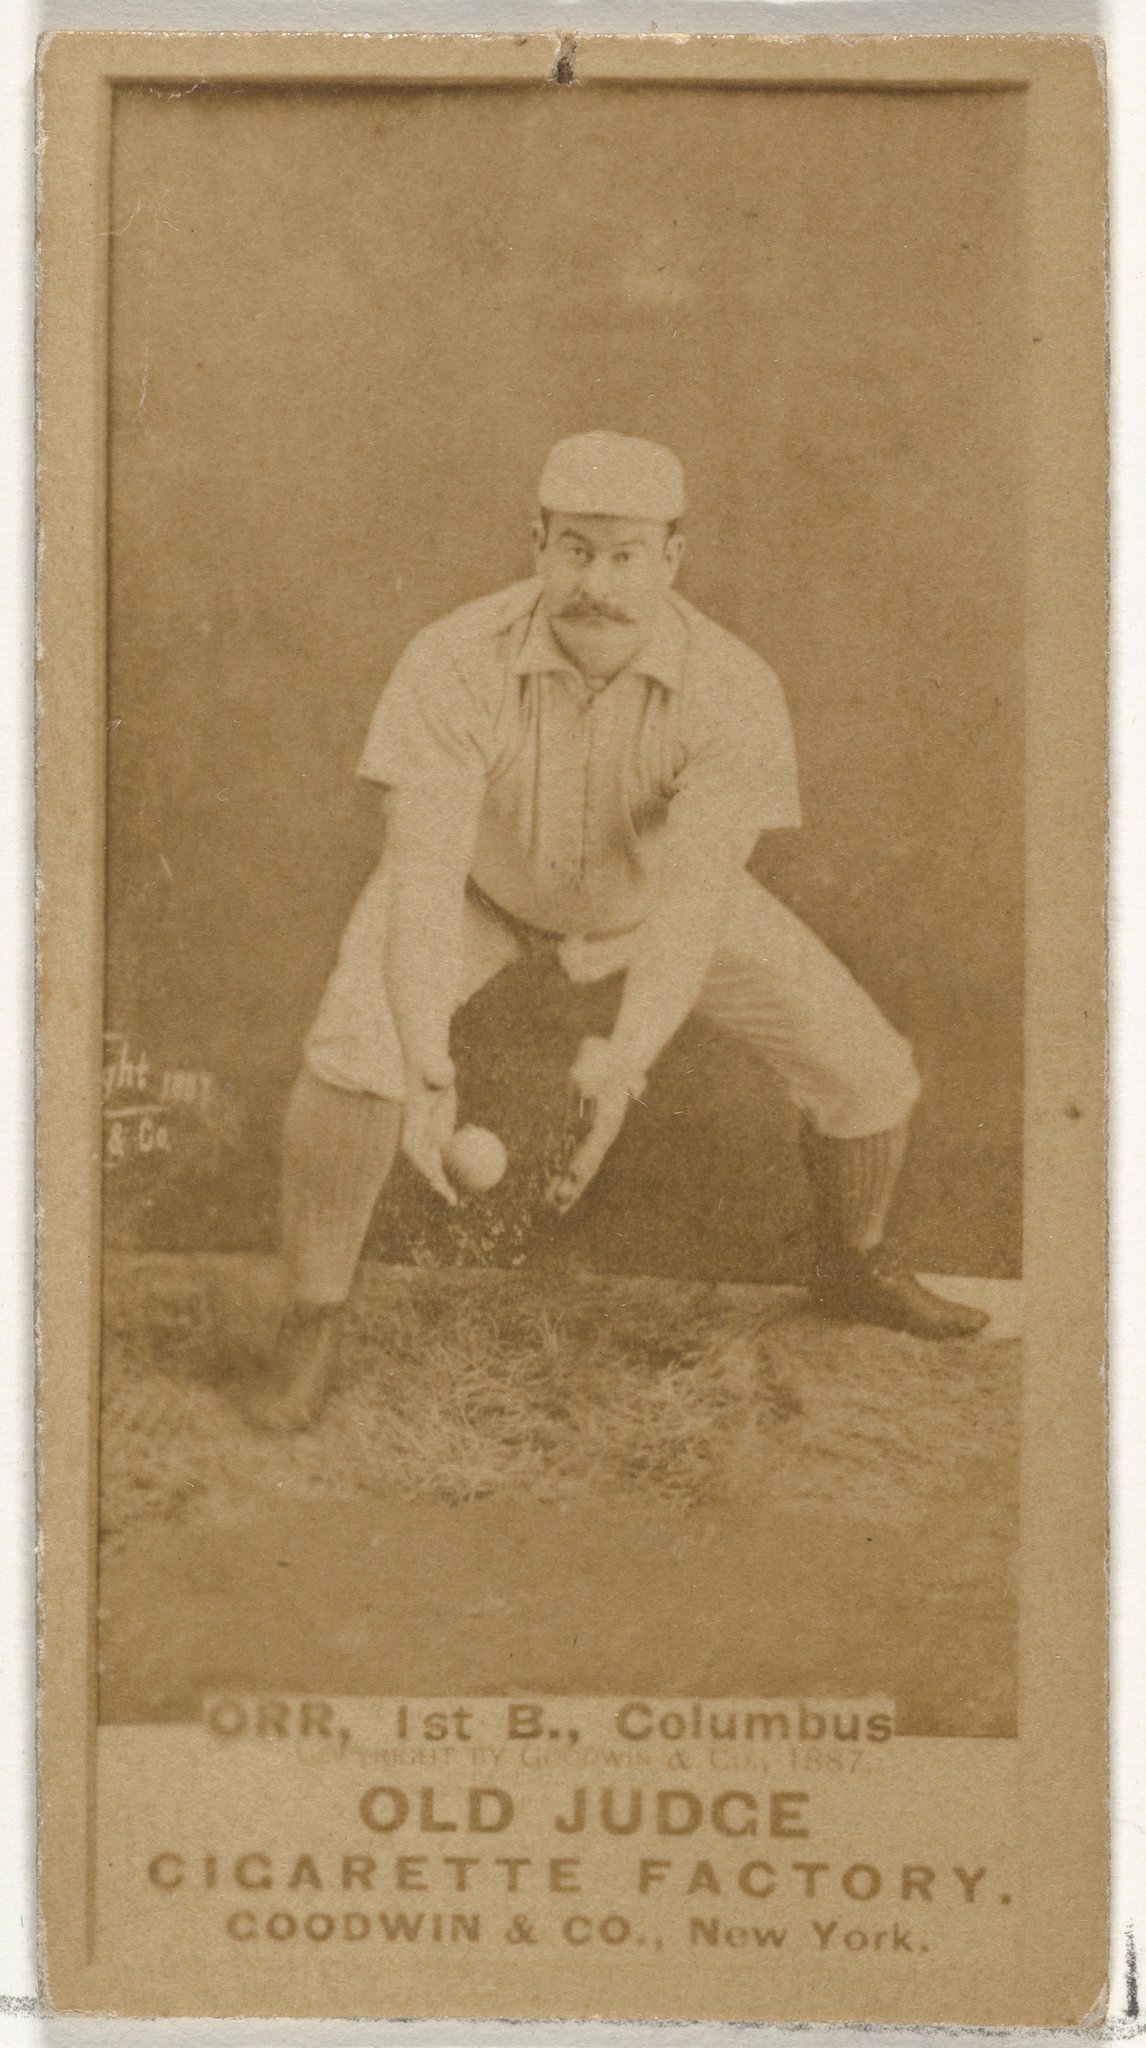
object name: baseball card, photograph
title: David L. "Dave" Orr, 1st Base, Cleveland, from the Old Judge series (N172) for Old Judge Cigarettes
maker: goodwin & company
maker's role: publisher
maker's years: 1850-1950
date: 1887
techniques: albumen silver print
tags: men,portraits,baseball,athletes